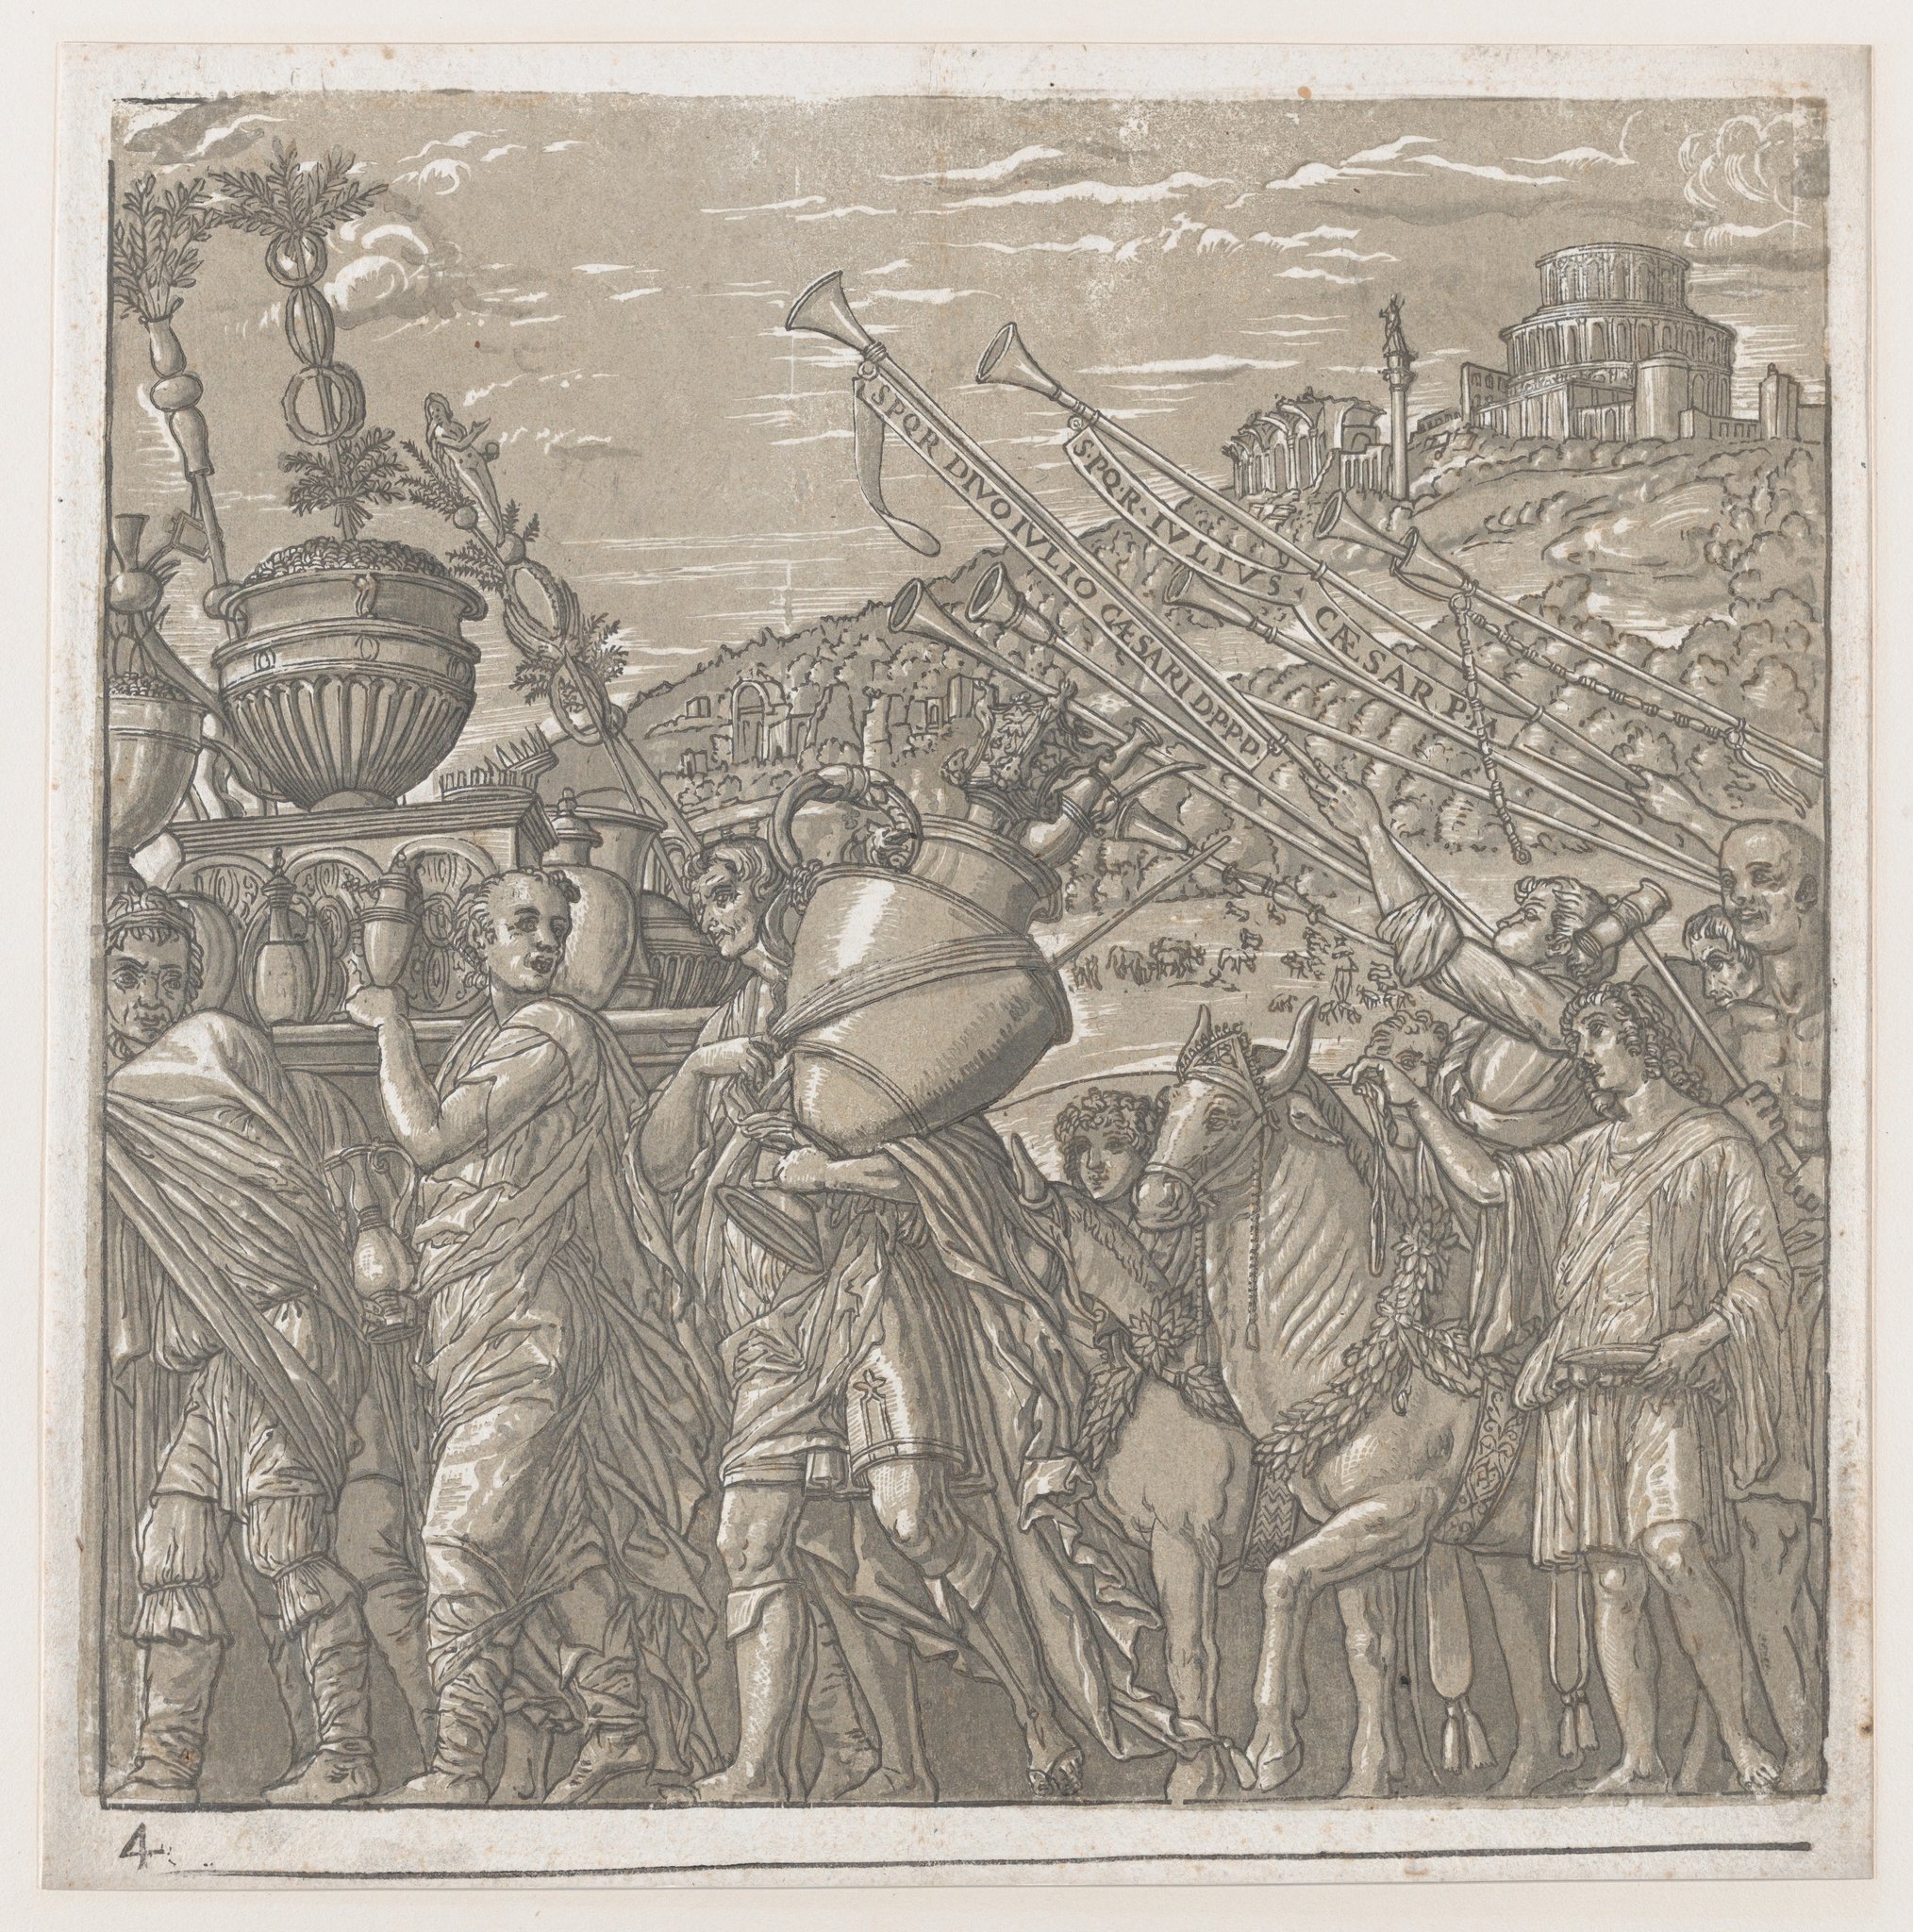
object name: print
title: Sheet 4: Men carrying trophies at left, trumpeters at right, from "The Triumph of Julius Caesar"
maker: andrea andreani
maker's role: artist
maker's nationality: italian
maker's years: 1558-1629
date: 1599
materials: ink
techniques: woodcut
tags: men,trumpets,horses,trophies